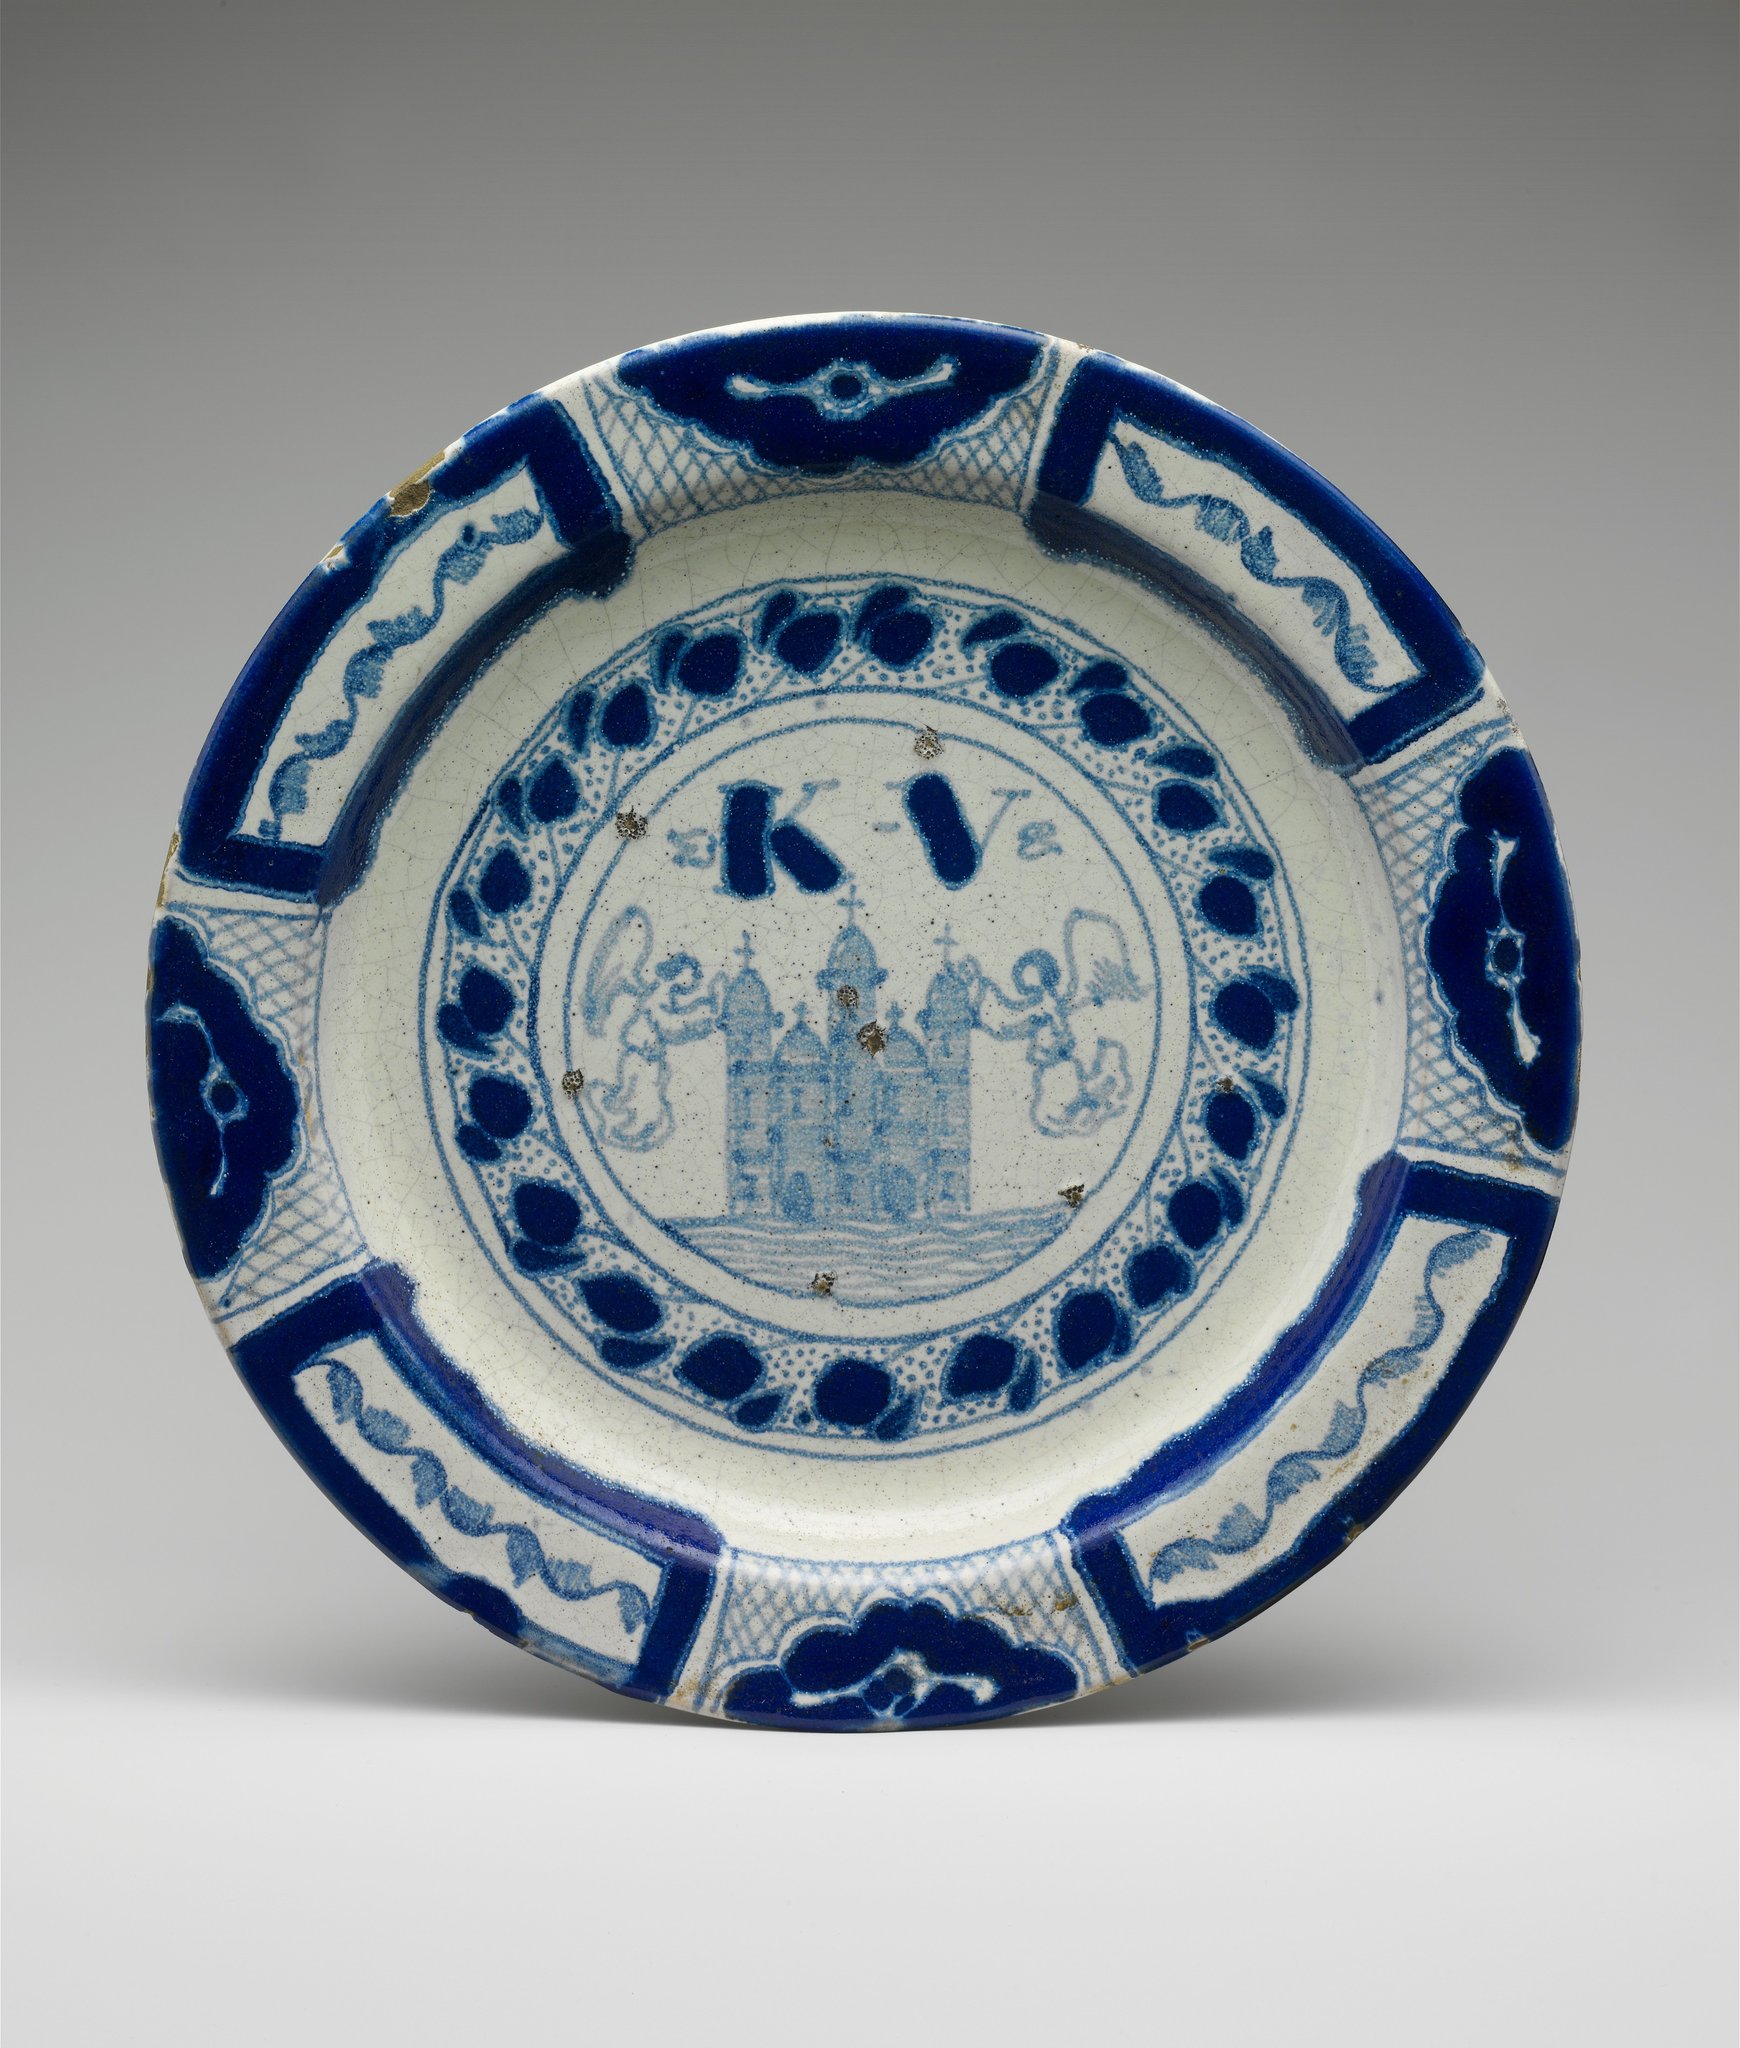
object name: dish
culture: mexican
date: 1875-1900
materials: earthenware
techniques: glazing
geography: mexico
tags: buildings,angels